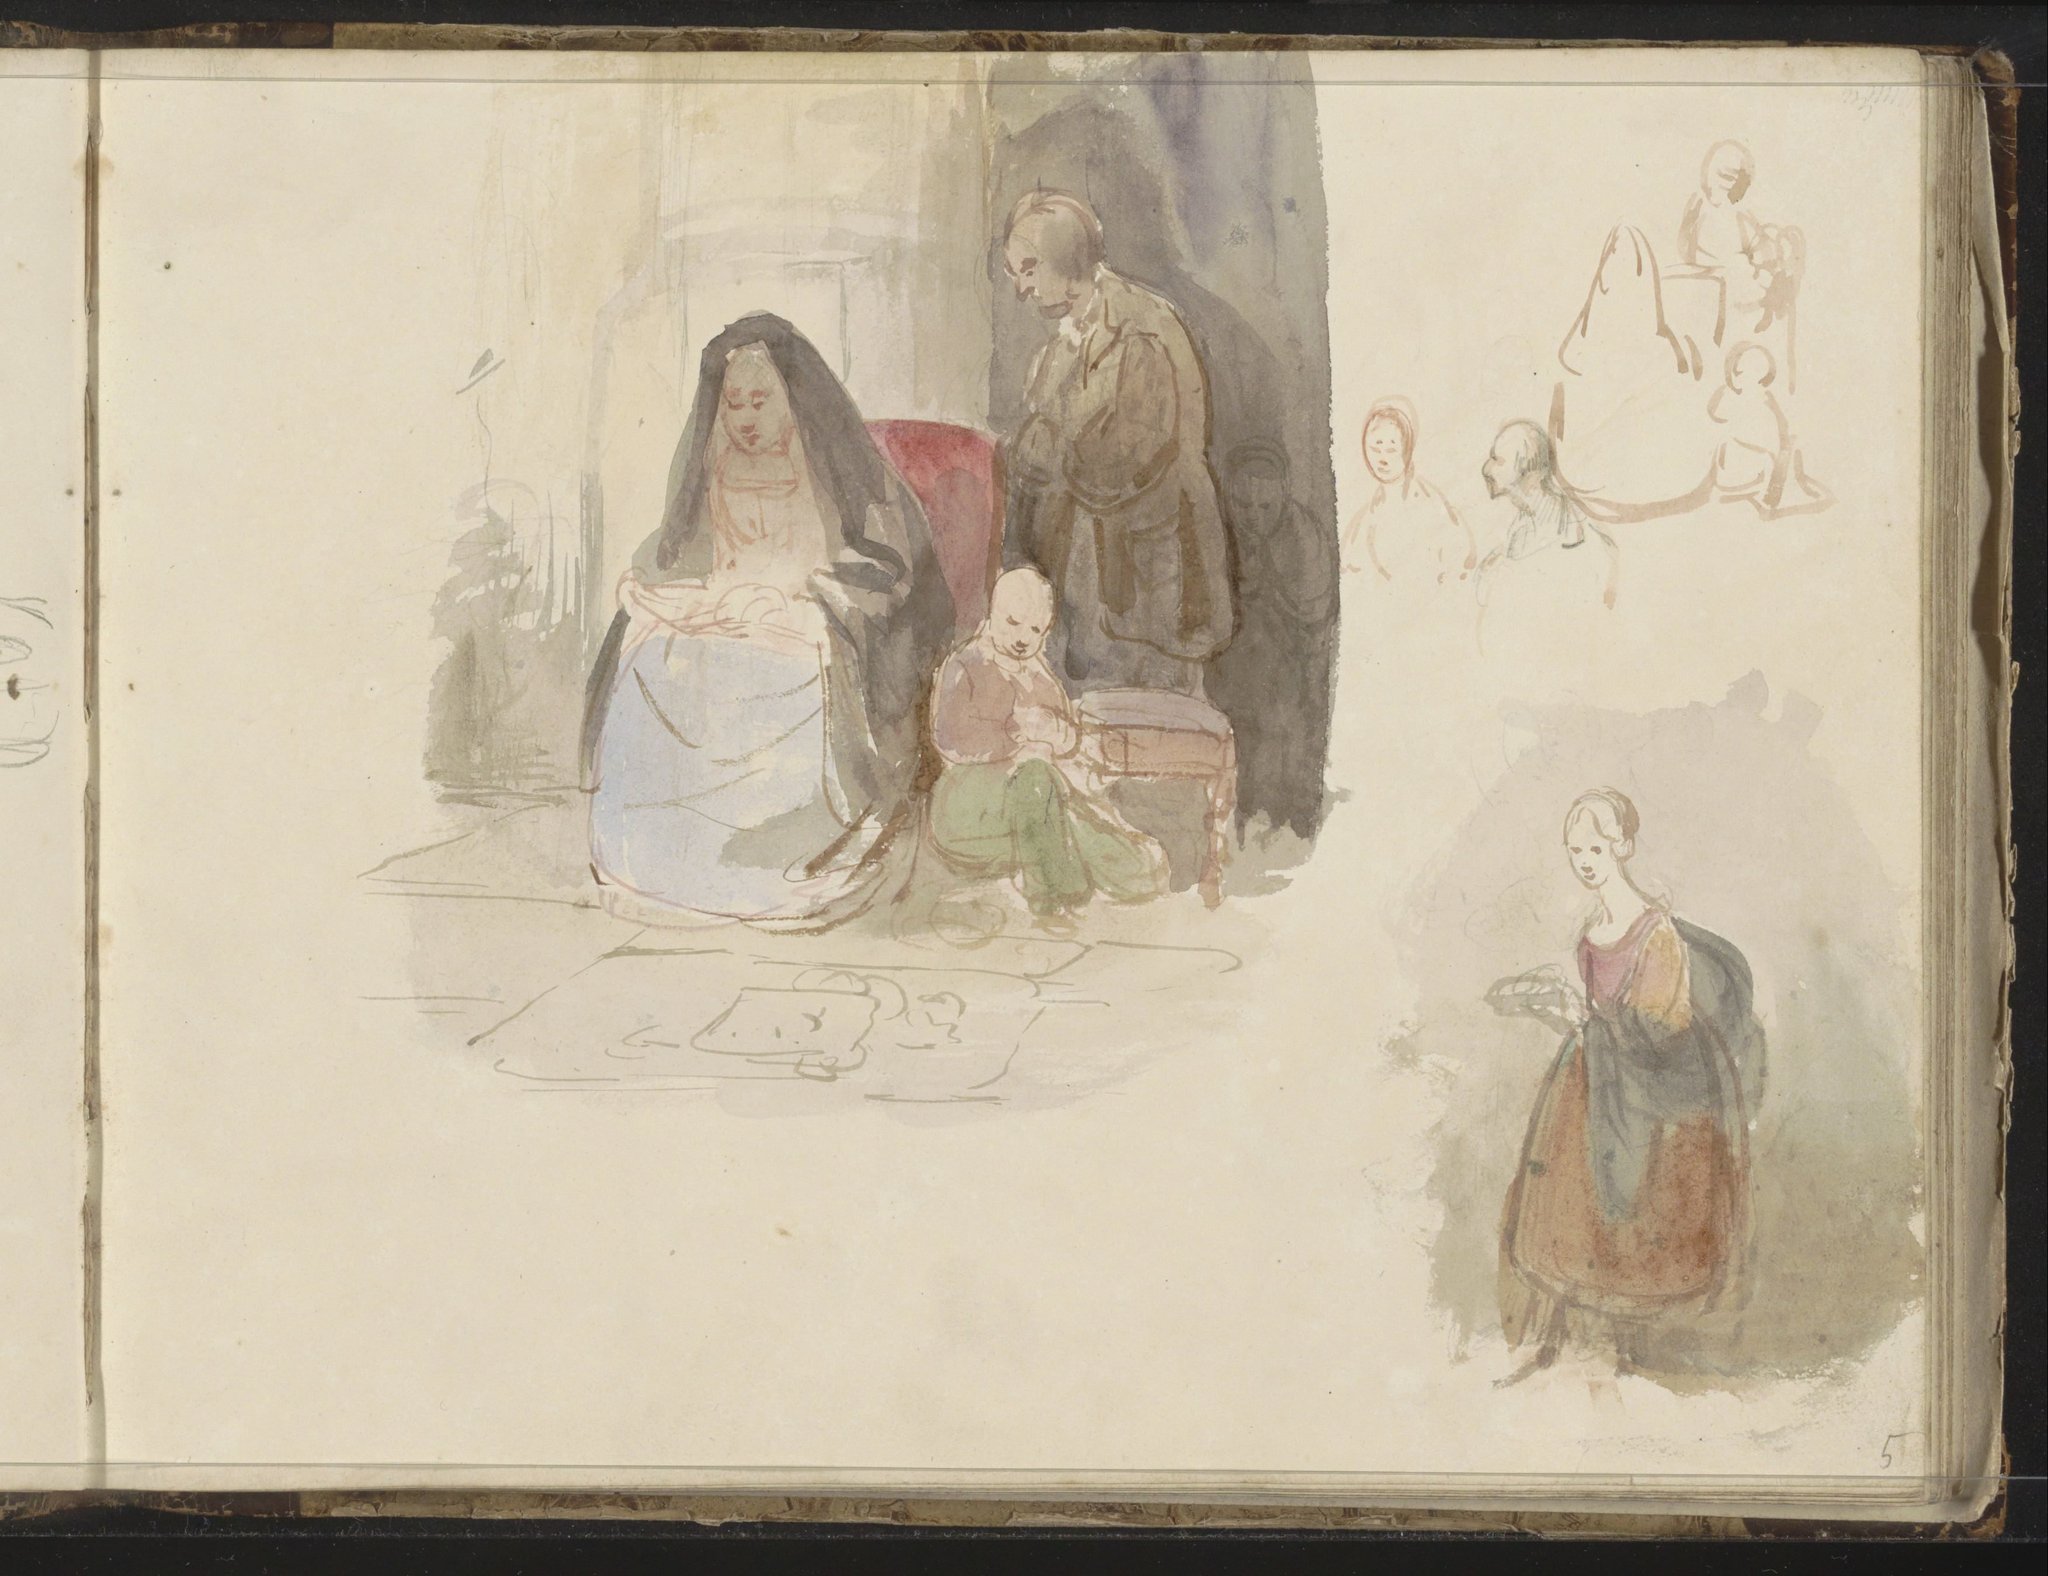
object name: sketchbook leaf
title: Studieblad met nonnen, figuren en koppen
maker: willem hendrik schmidt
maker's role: draughtsman, painter, print maker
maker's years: 1809-1849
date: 1819-1849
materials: paper, pencil, watercolor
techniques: brush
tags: head (human), nun(s)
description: Blad 5 recto uit een schetsboek met 52 bladen.